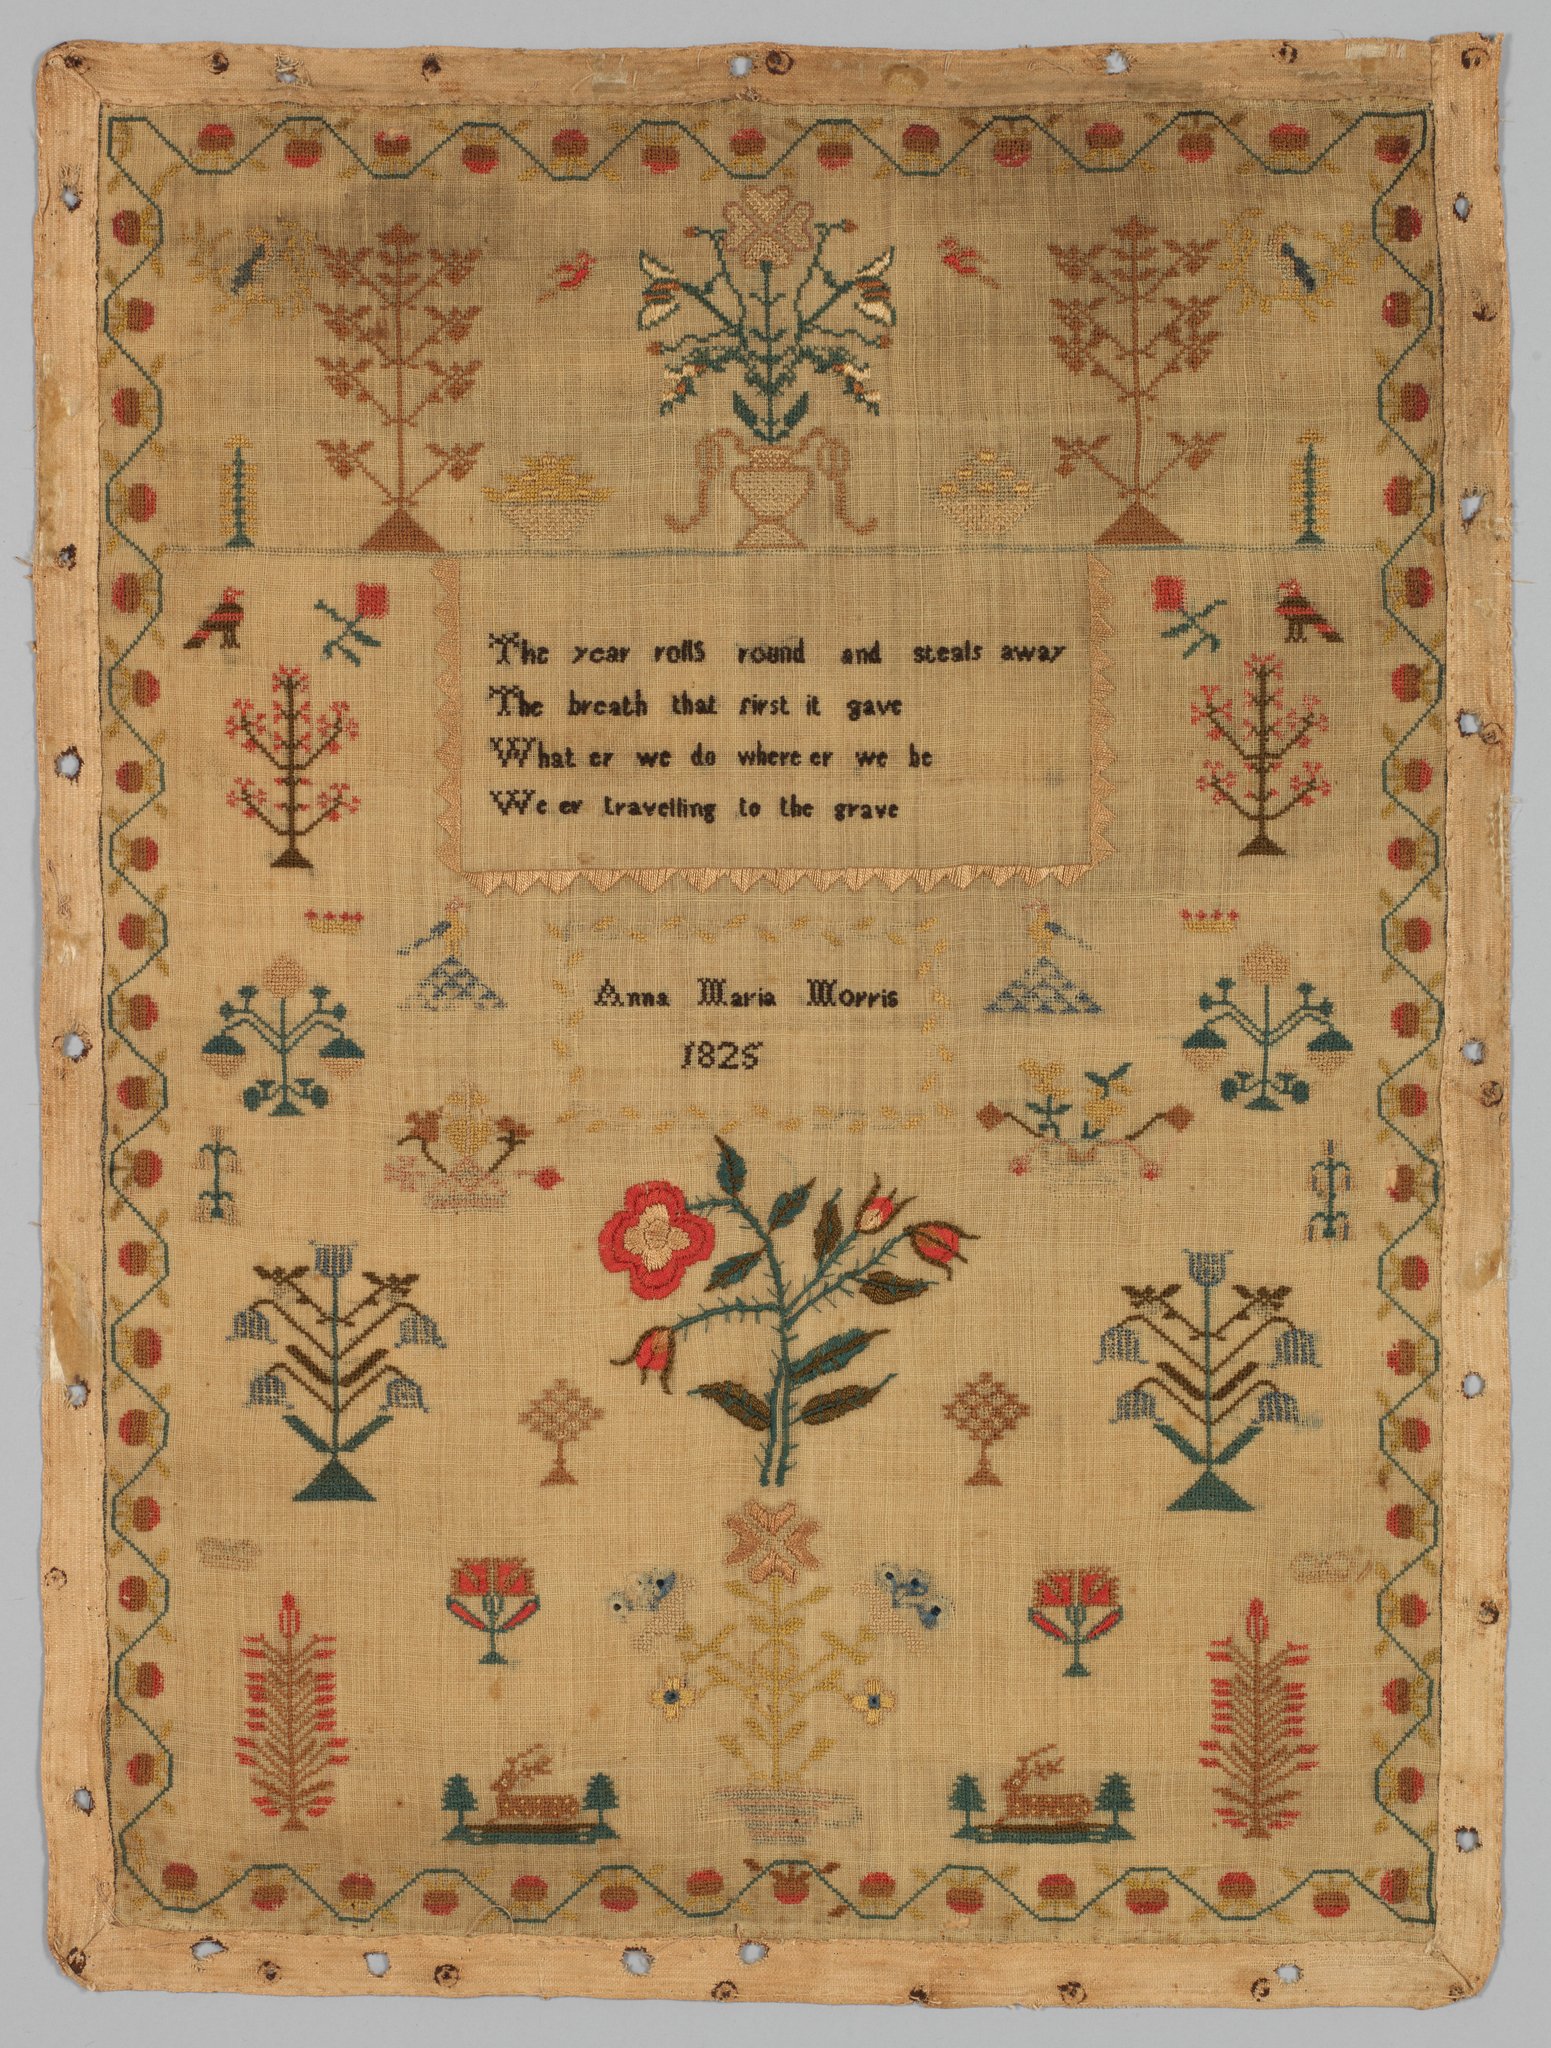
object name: sampler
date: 1825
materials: canvas, silk, wool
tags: flowers